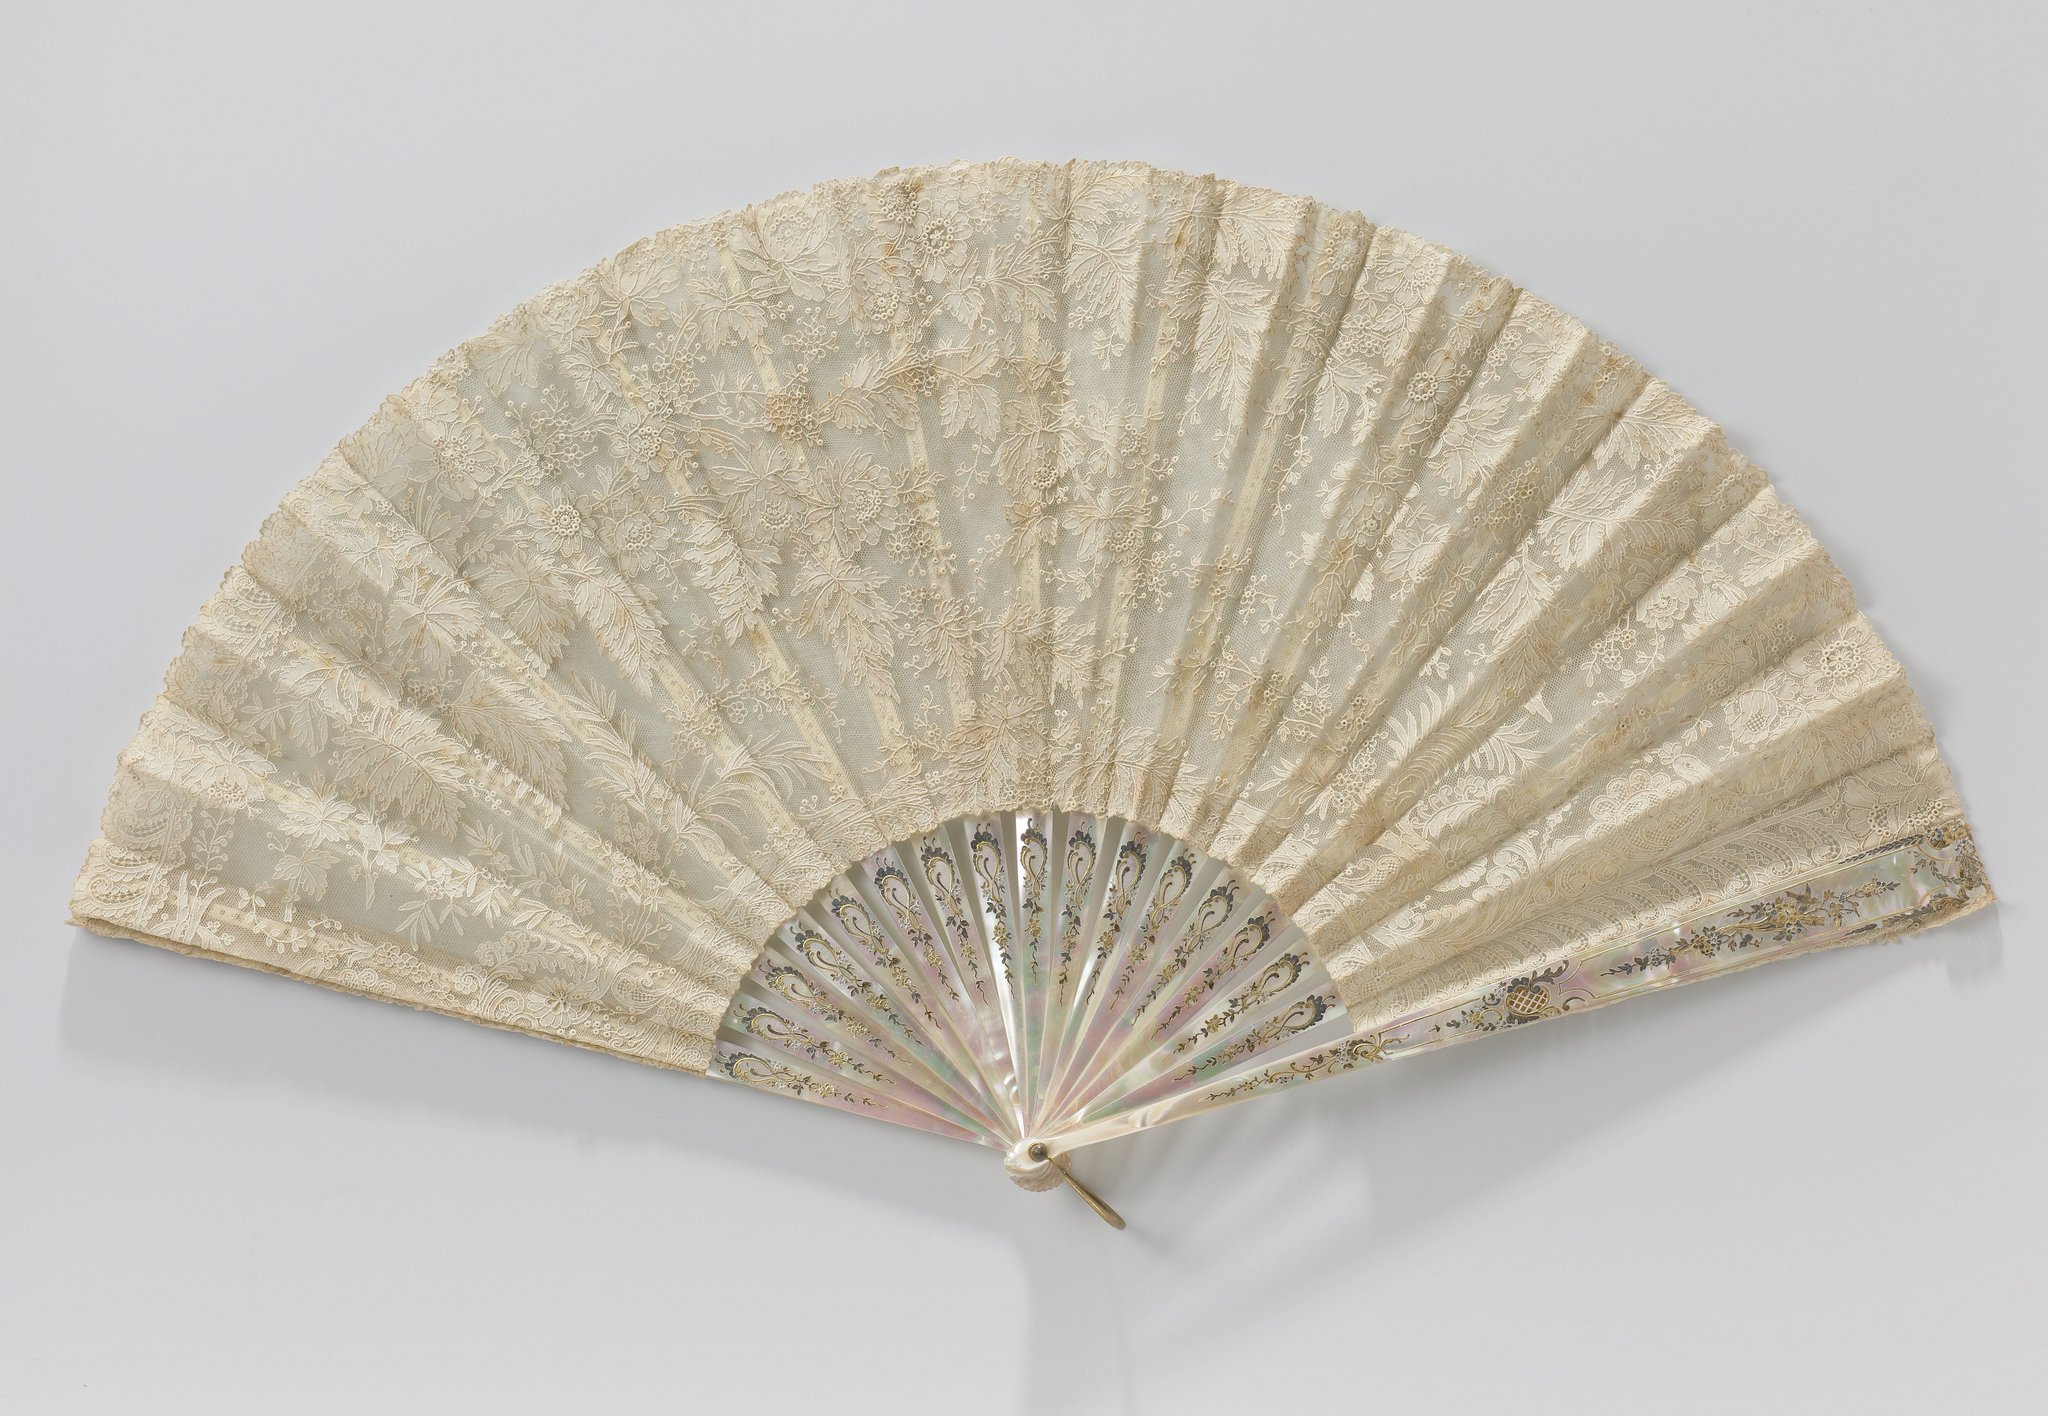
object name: vouwwaaier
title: Vouwwaaier met blad van Brussels naaldkant op een montuur van parelmoer voorzien van 'métal en quatre couleurs'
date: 1865-1875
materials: copper, ivory, mother of pearl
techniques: cutting, embroidered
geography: new york city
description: Parelmoer montuur met 18 niet aaneengesloten benen met Rococo ornamenten in "quatre couleurs" ingelegd. De staken van het steundeel zijn van gesneden ivoor. In de buitenbenen met één cartouche met servetwerk. Blad van Brussels naaldkant (point a l'aiguille de Bruxelles of point de gaze de Bruxelles) met bloemen en bladeren. Koperen waaierring en sluitpin.